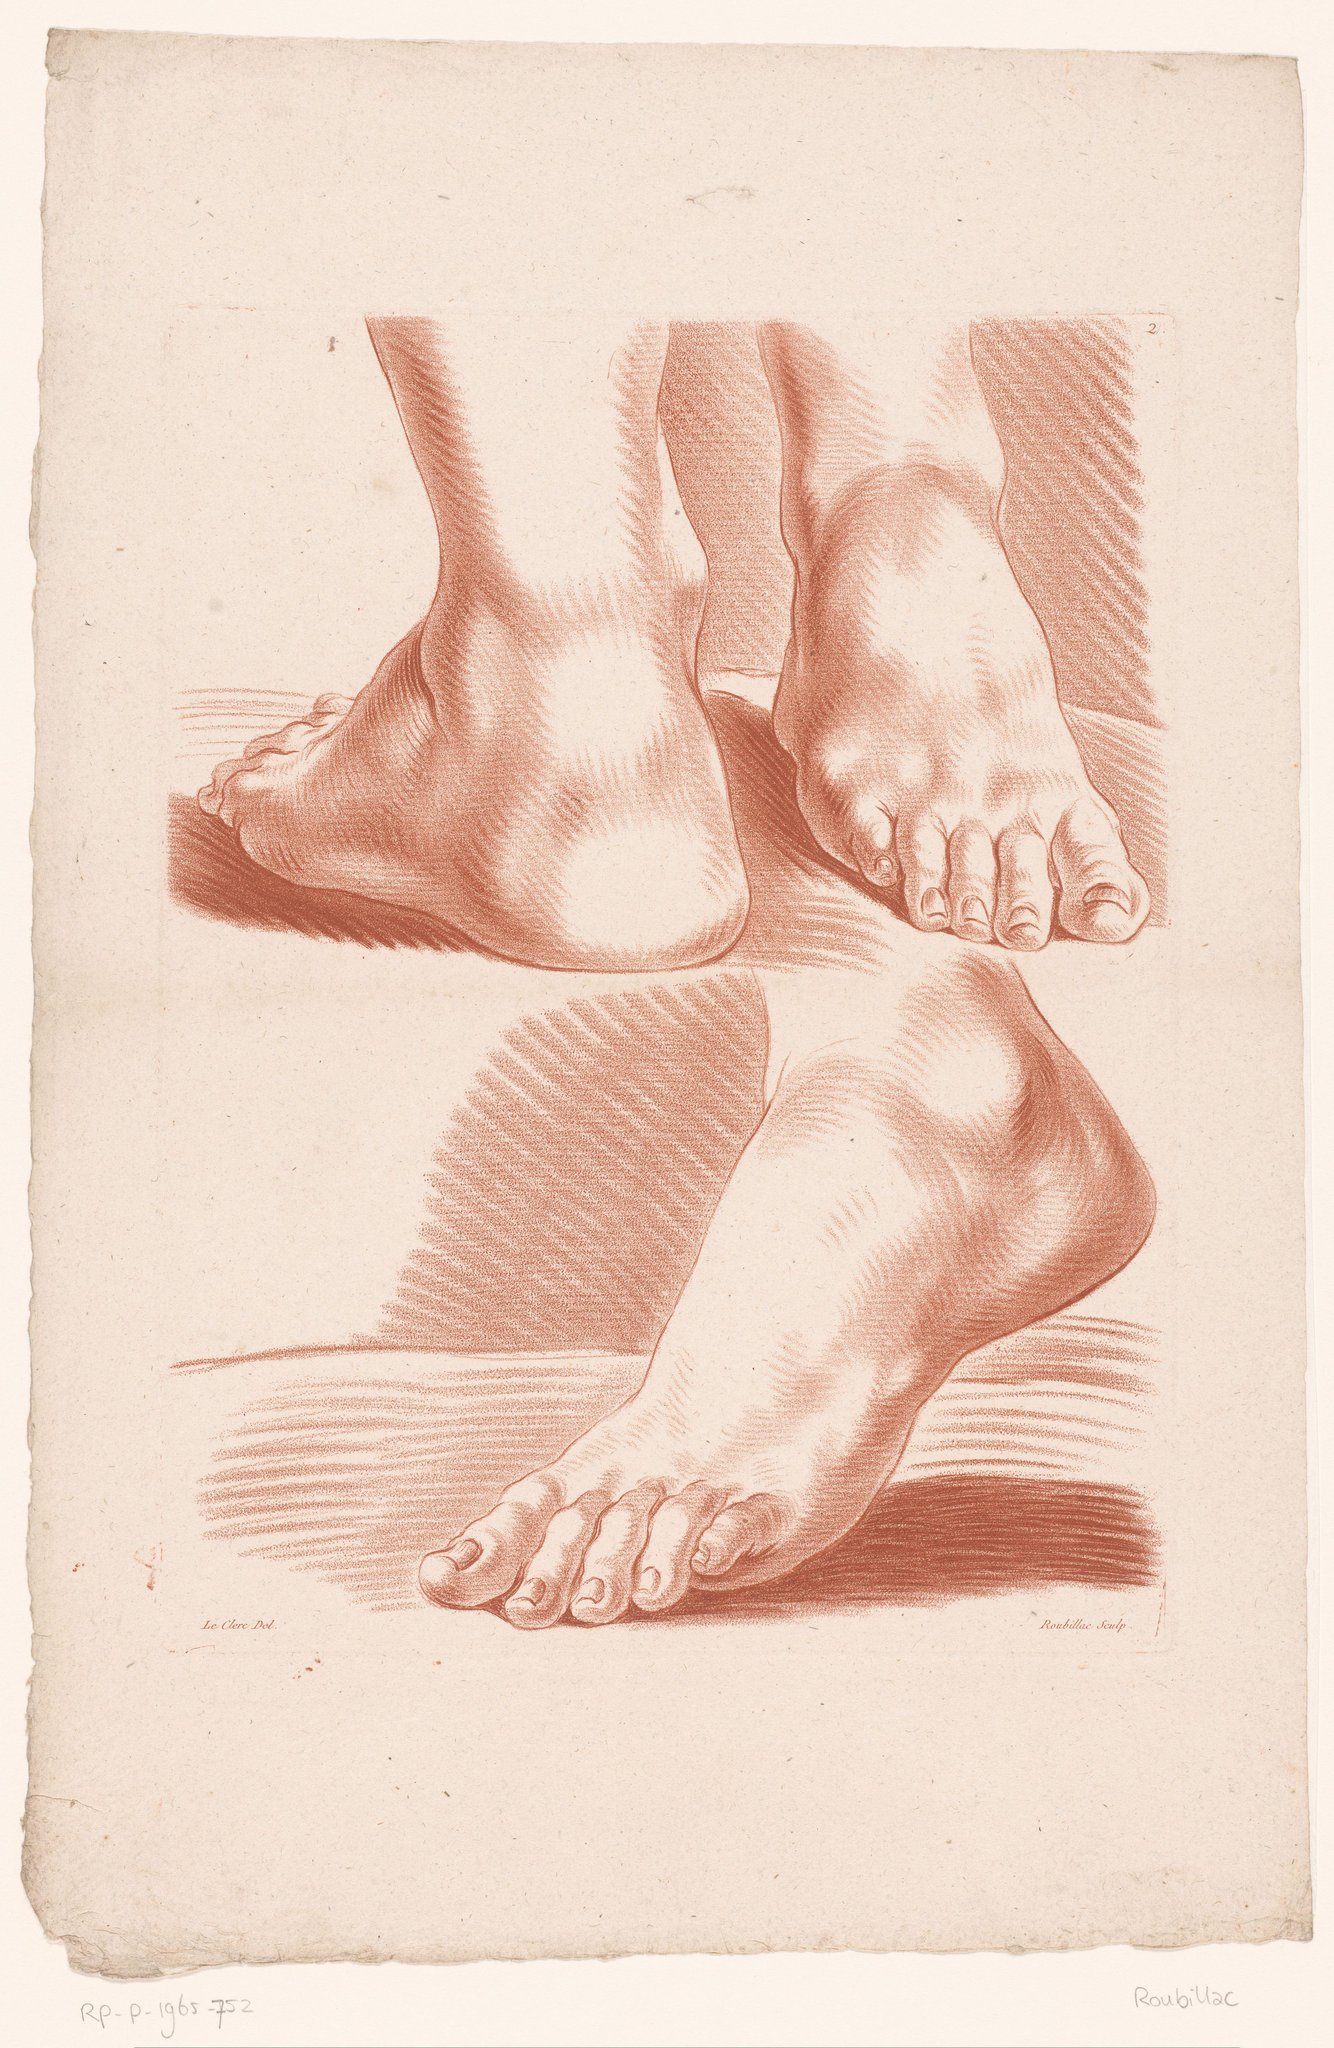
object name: print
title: Ve Cahier de Principes du Dessin d'après Nature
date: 1784-1796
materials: paper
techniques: printmaking, etching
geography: paris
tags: drawing, sketch, foot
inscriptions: collector's mark: Lugt 2228